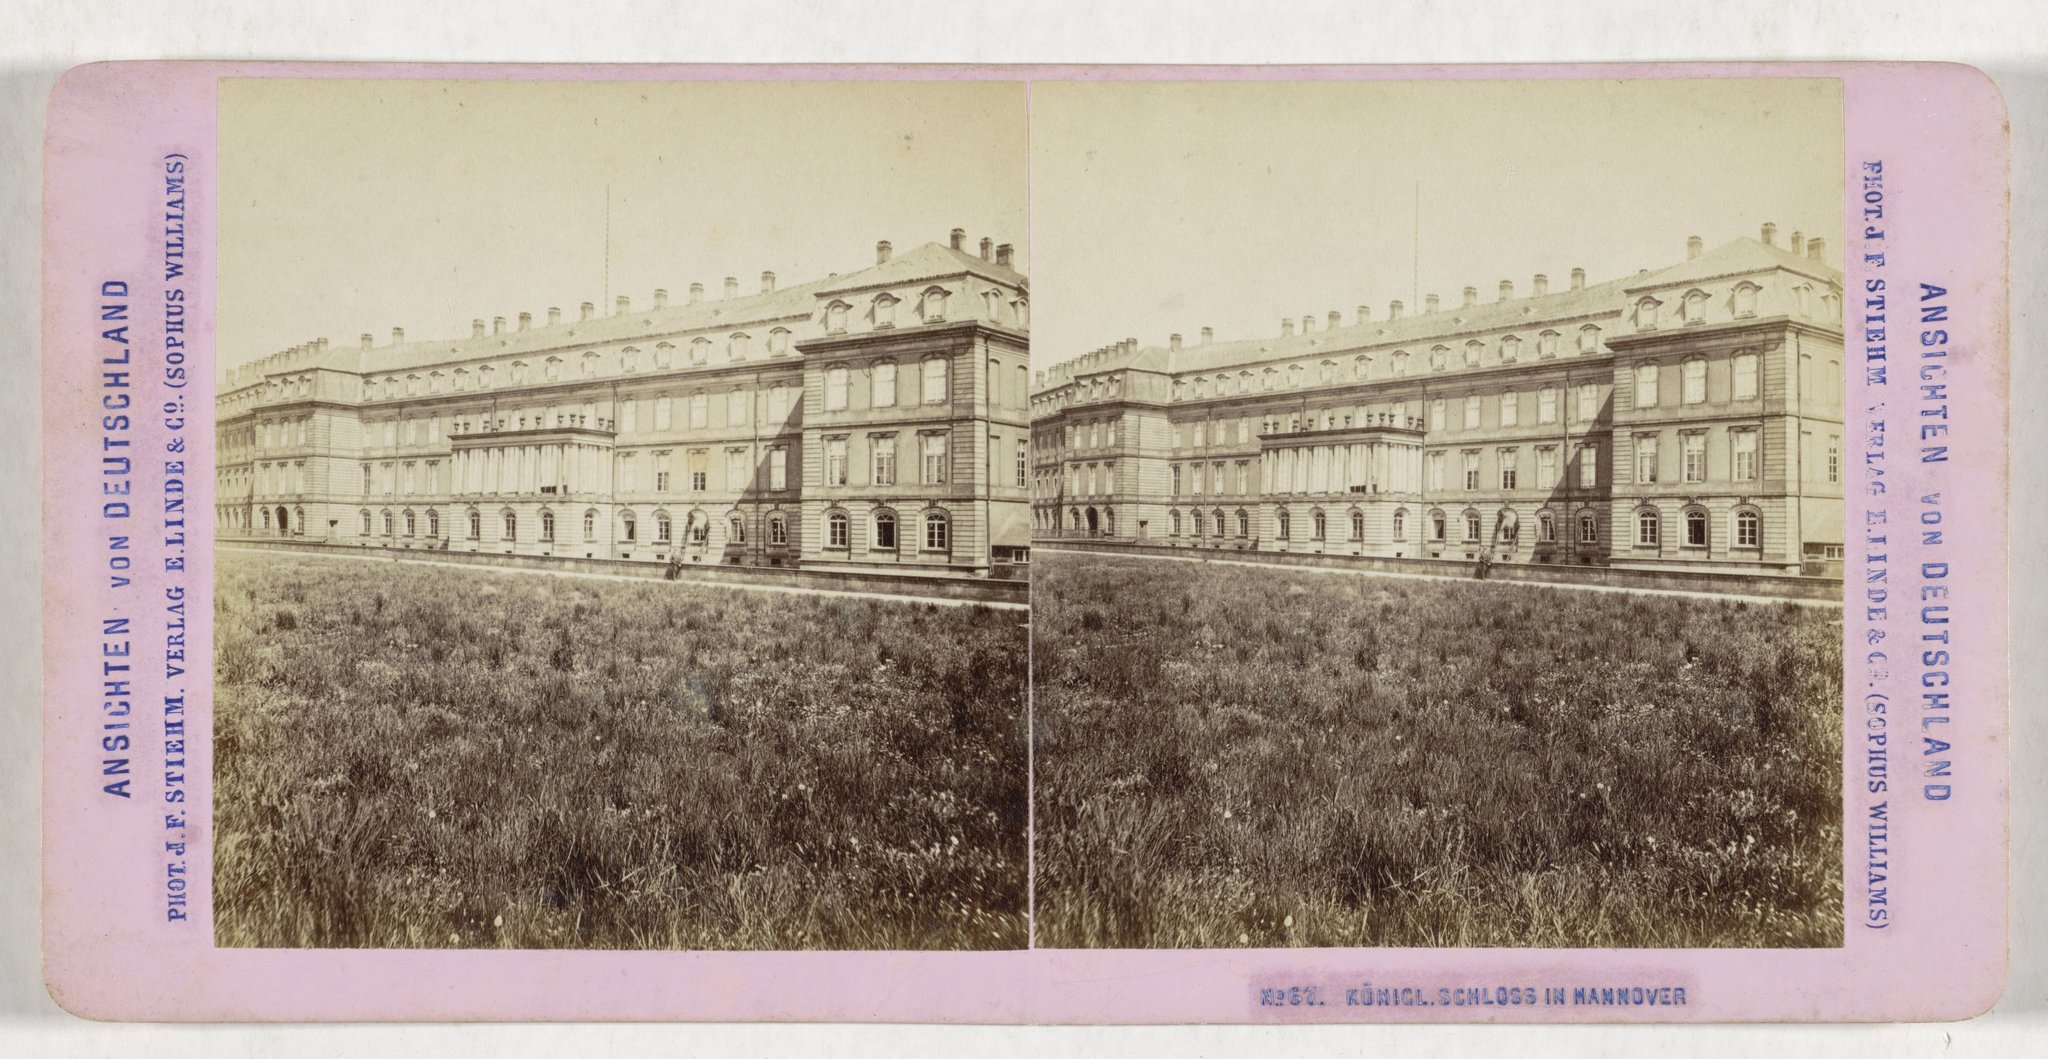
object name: stereograph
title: Ansichten von Deutschland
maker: johann friedrich stiehm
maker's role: fotograaf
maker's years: 1826-1902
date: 1869-1872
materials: cardboard, paper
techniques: albumen print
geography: hannover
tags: palace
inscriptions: number: ‘No 67.’